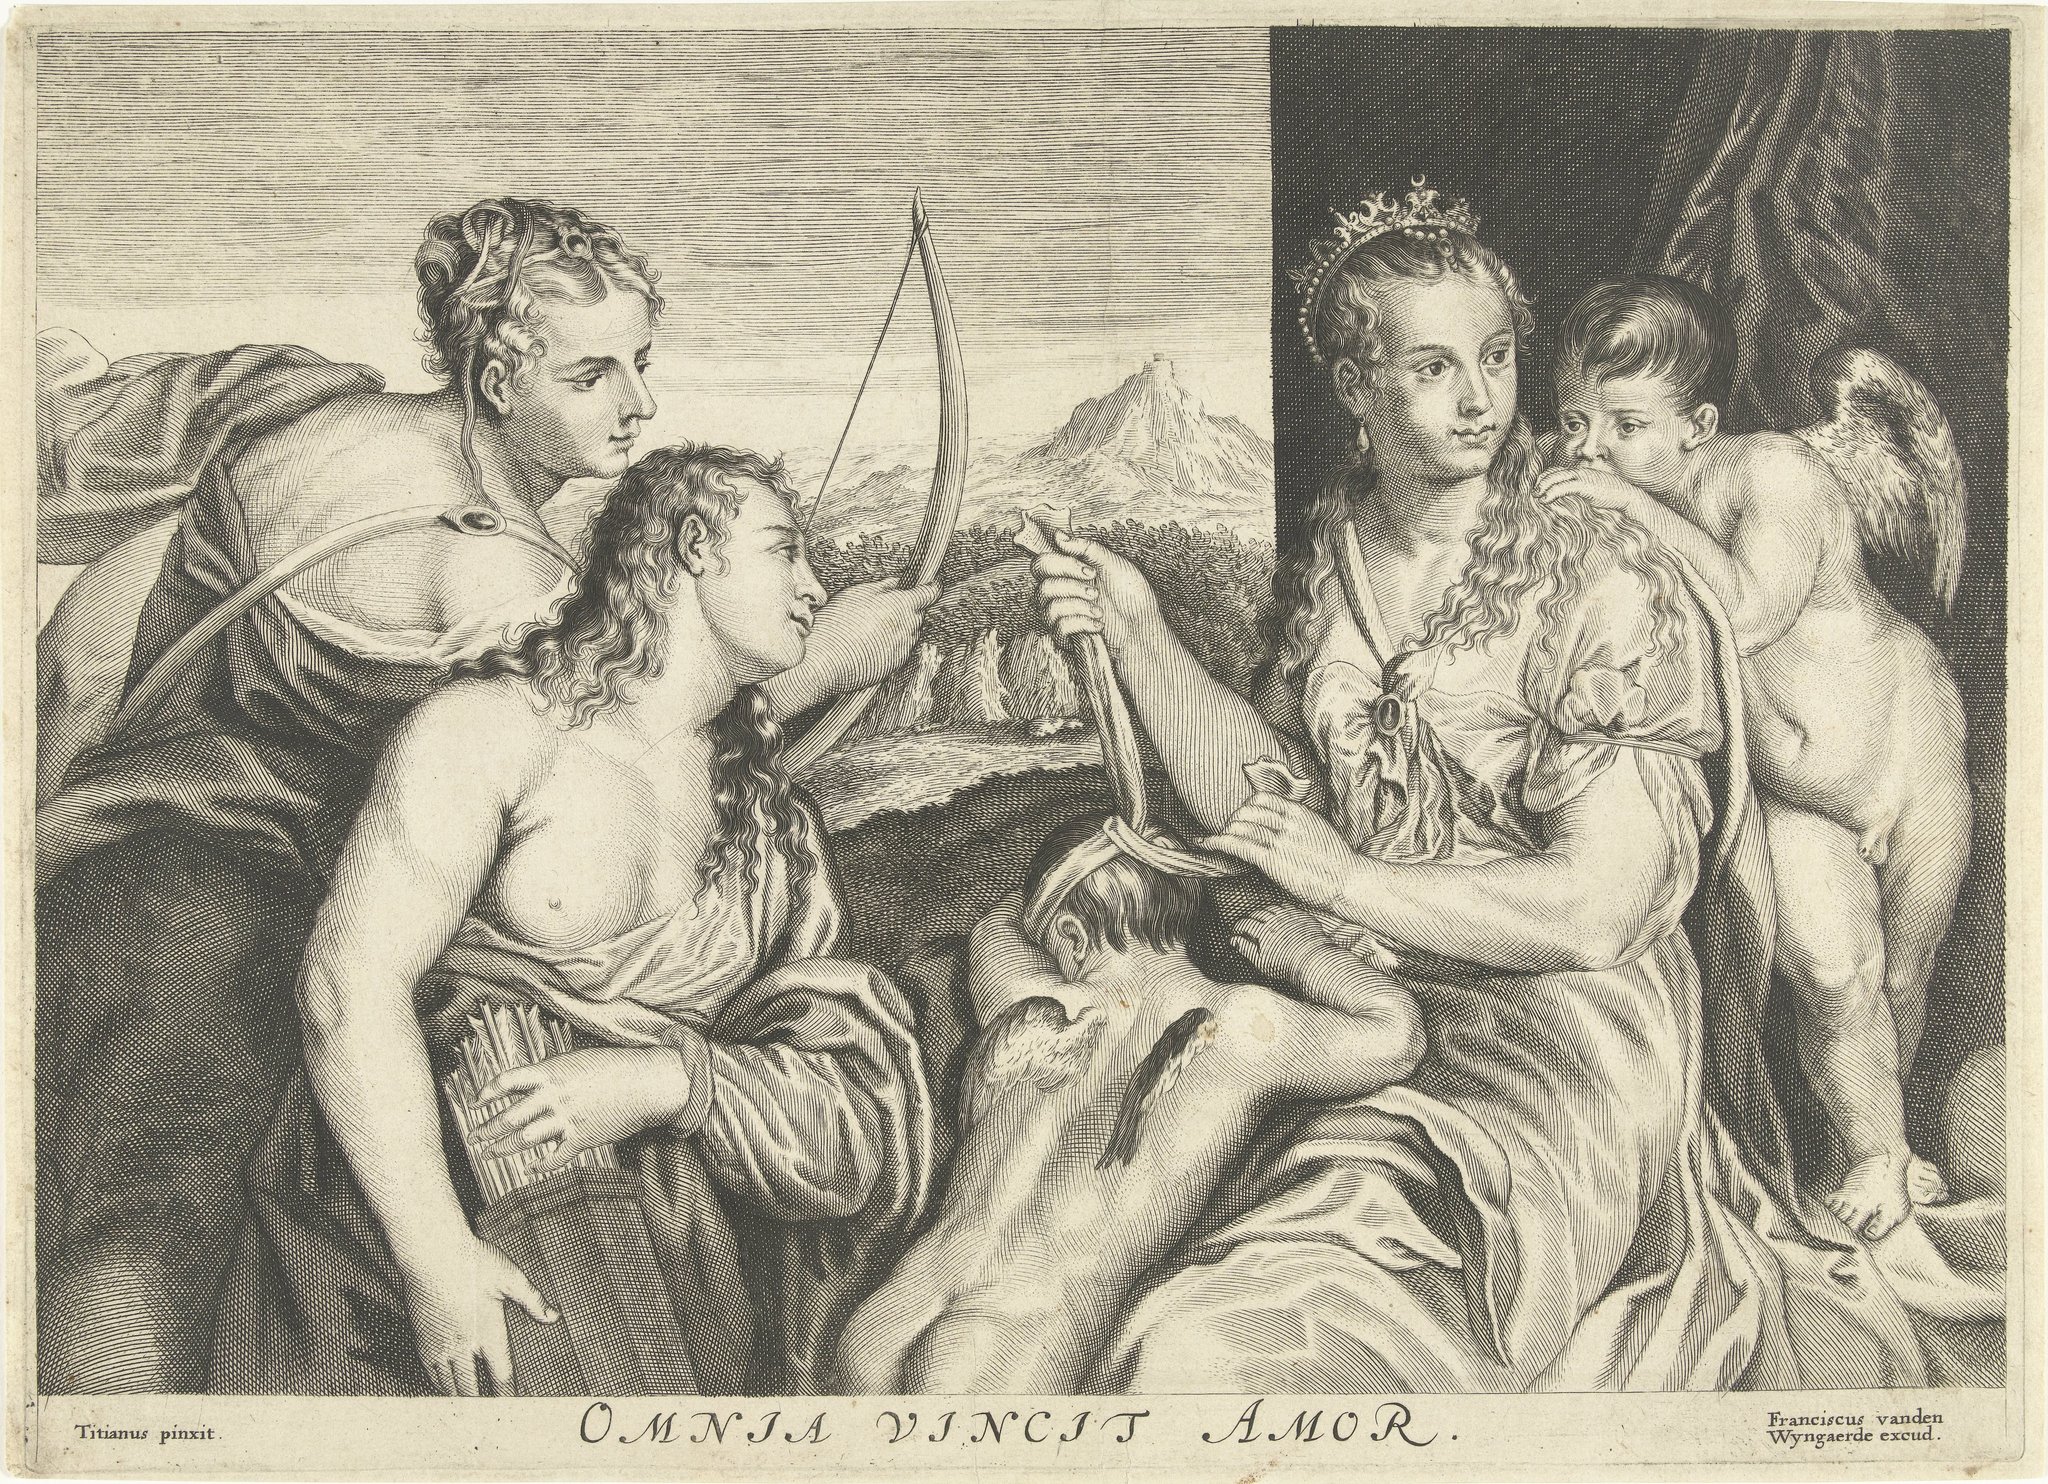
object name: print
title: Venus blinddoekt Amor en twee nimfen dragen pijlen en boog, allegorie op de liefde die alles overwint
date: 1635-1679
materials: paper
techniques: engraving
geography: amsterdam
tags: attributes of cupid: arrow(s), (story of) cupid, amor (eros), attributes of cupid: bow, 'omnia vincit amor', love the conqueror, love triumphant, attributes of cupid: blindfold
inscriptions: collector's mark: Lugt 240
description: Allegorie op de liefde die alles overwint: Venus blinddoekt Amor en twee nimfen dragen pijlen en boog.